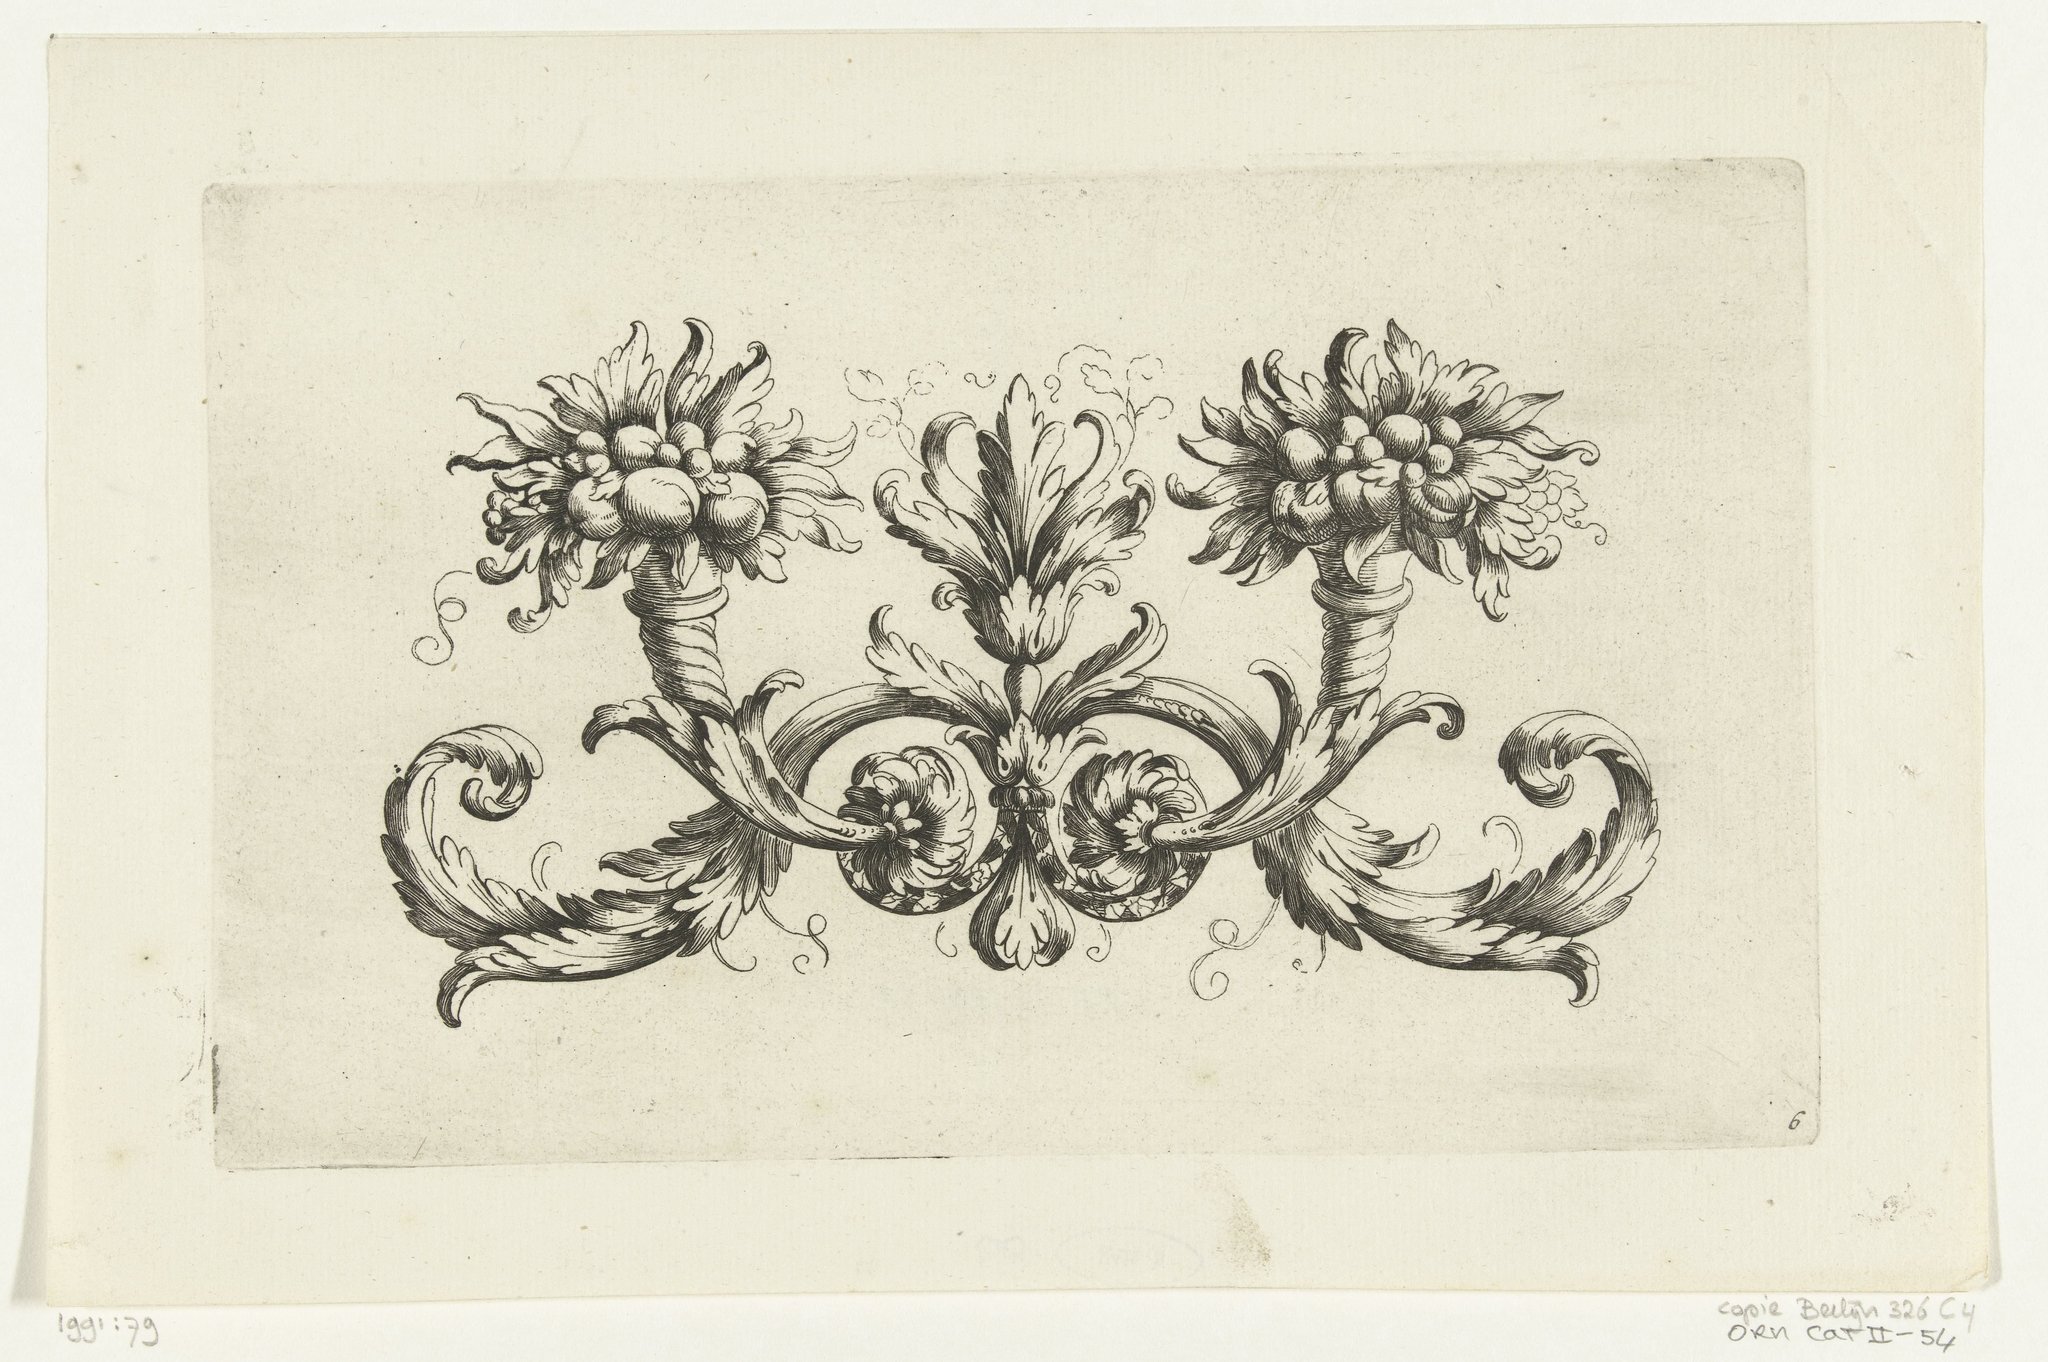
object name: print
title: Fries met hoorns des overvloeds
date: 1680-1690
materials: paper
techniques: etching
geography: amsterdam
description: In het midden een bloemkelk boven twee rozetten, waaruit twee hoorns des overvloeds komen. Nederlandse kopie naar het bovenste motief van blad 4 uit de originele serie met dezelfde naam.